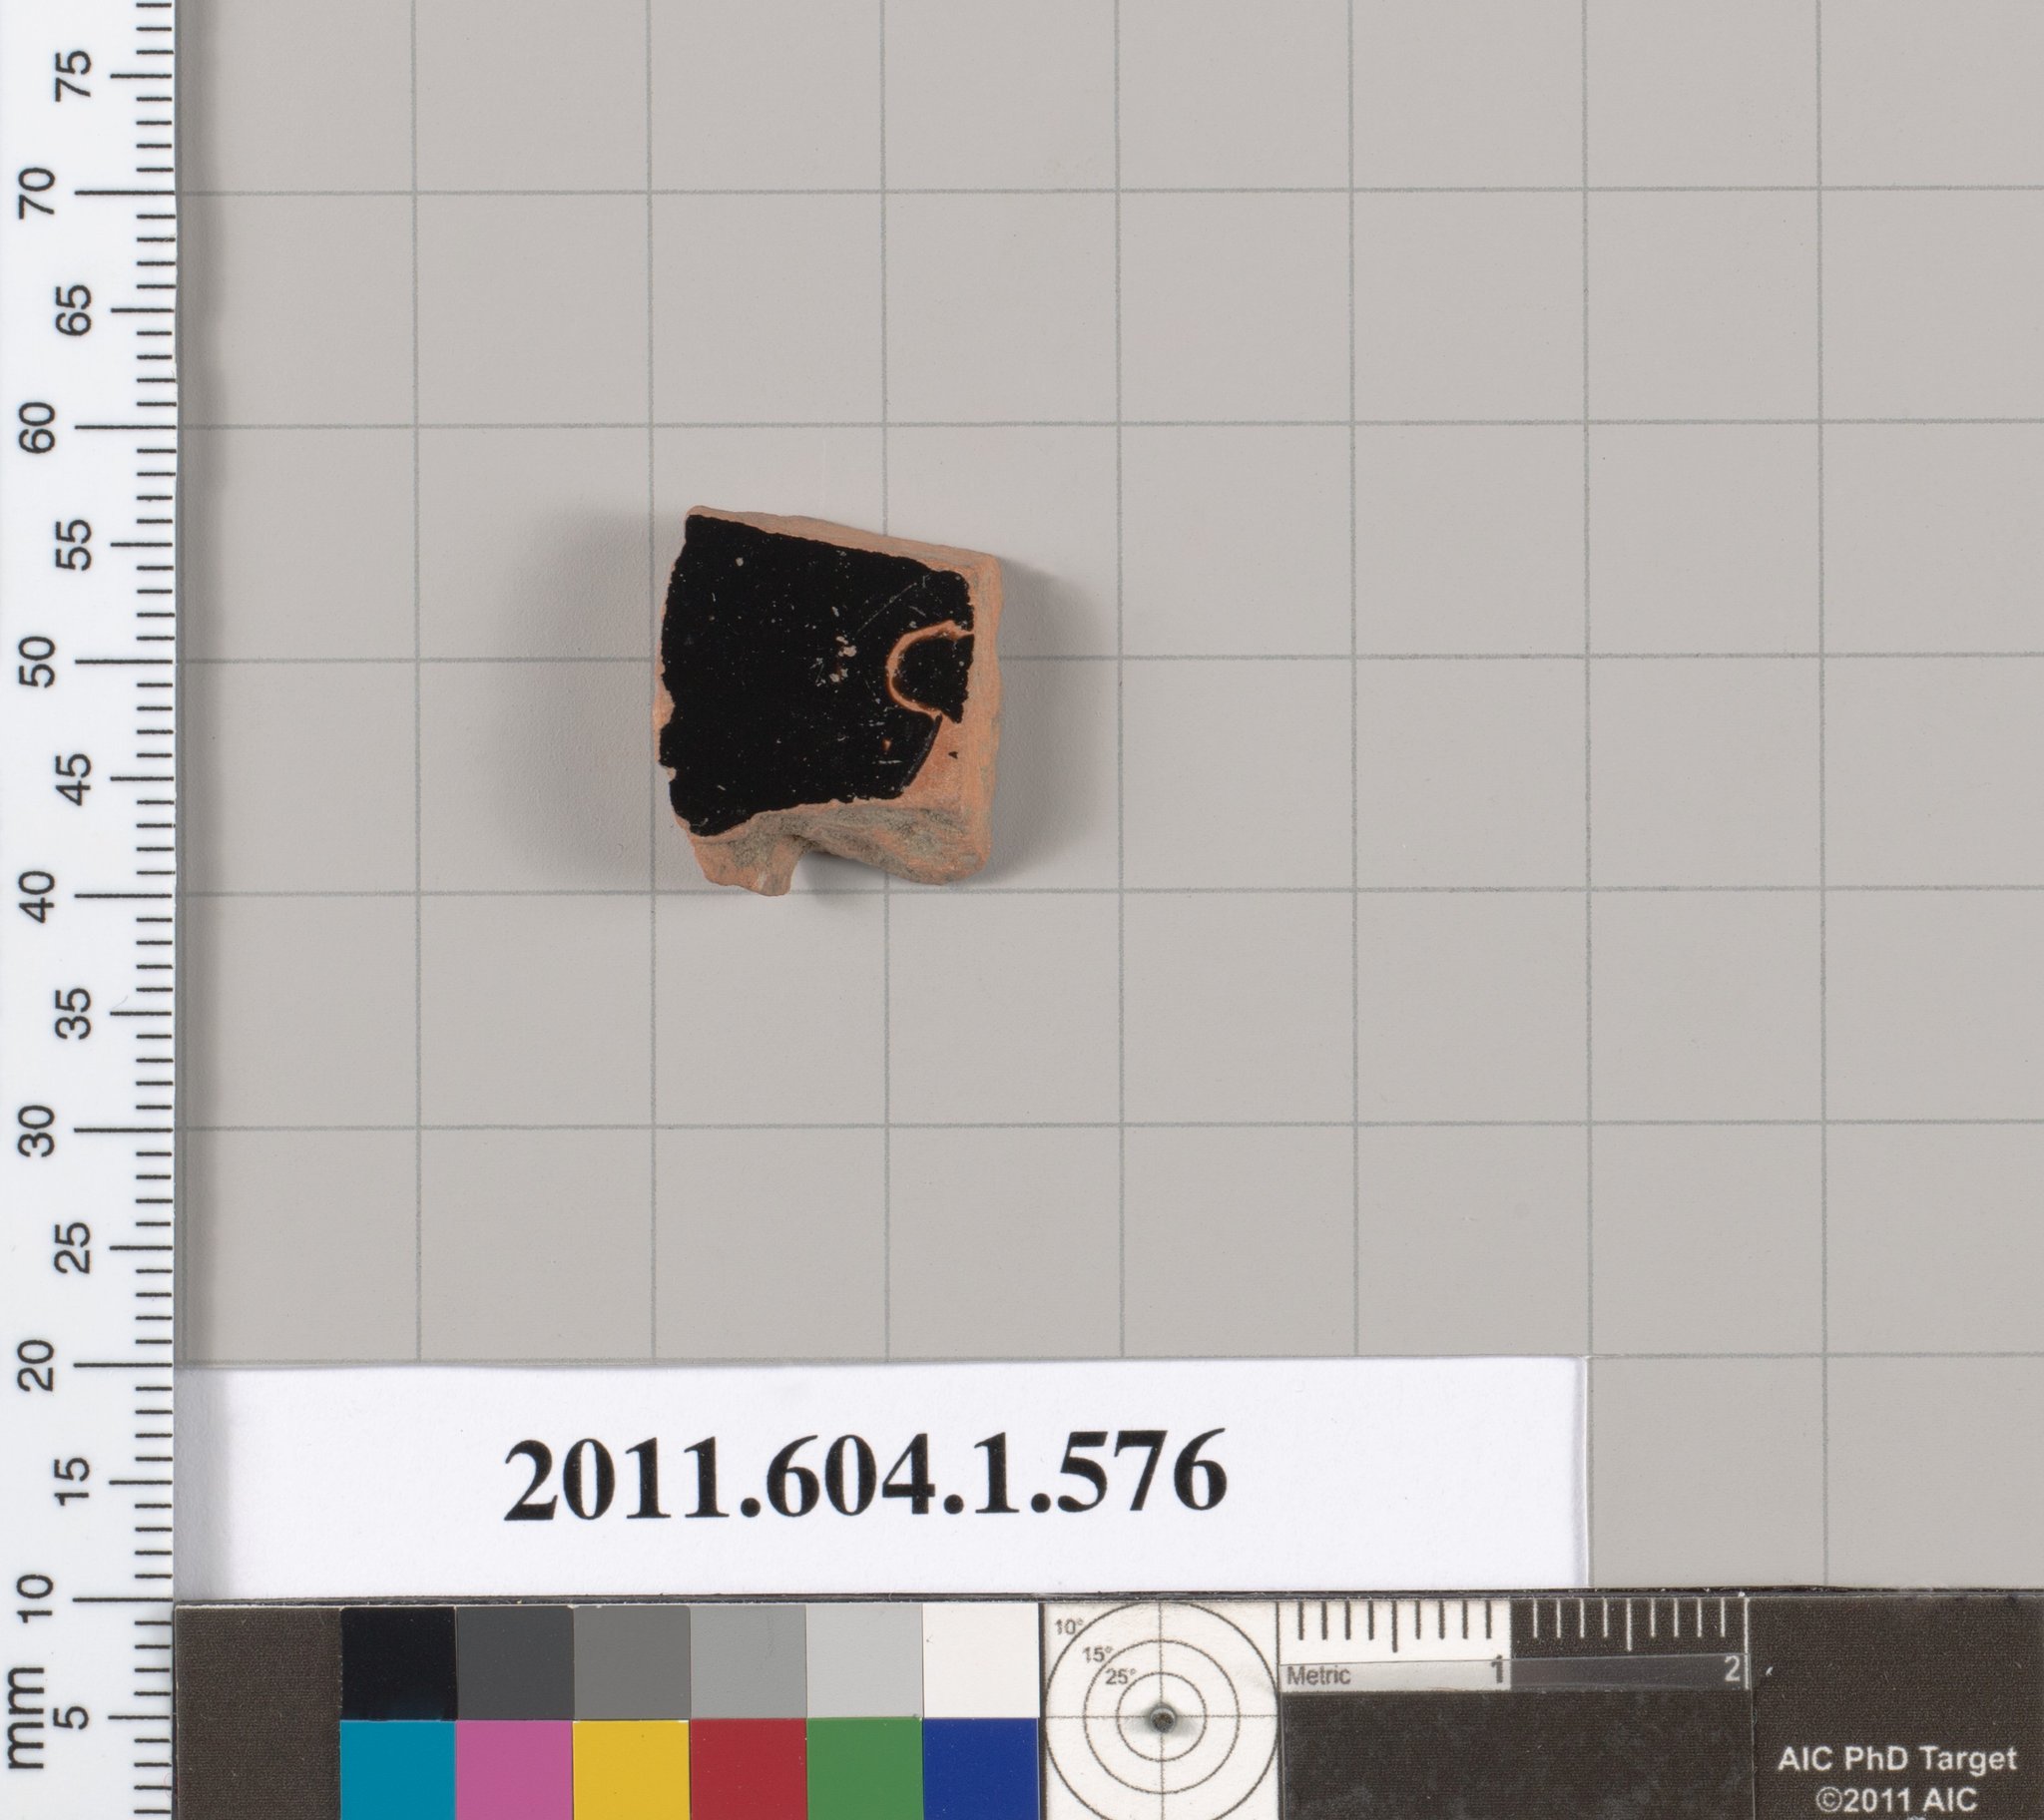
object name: kylix fragment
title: Terracotta fragment of a kylix (drinking cup)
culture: greek, attic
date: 475-451 BCE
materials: terracotta